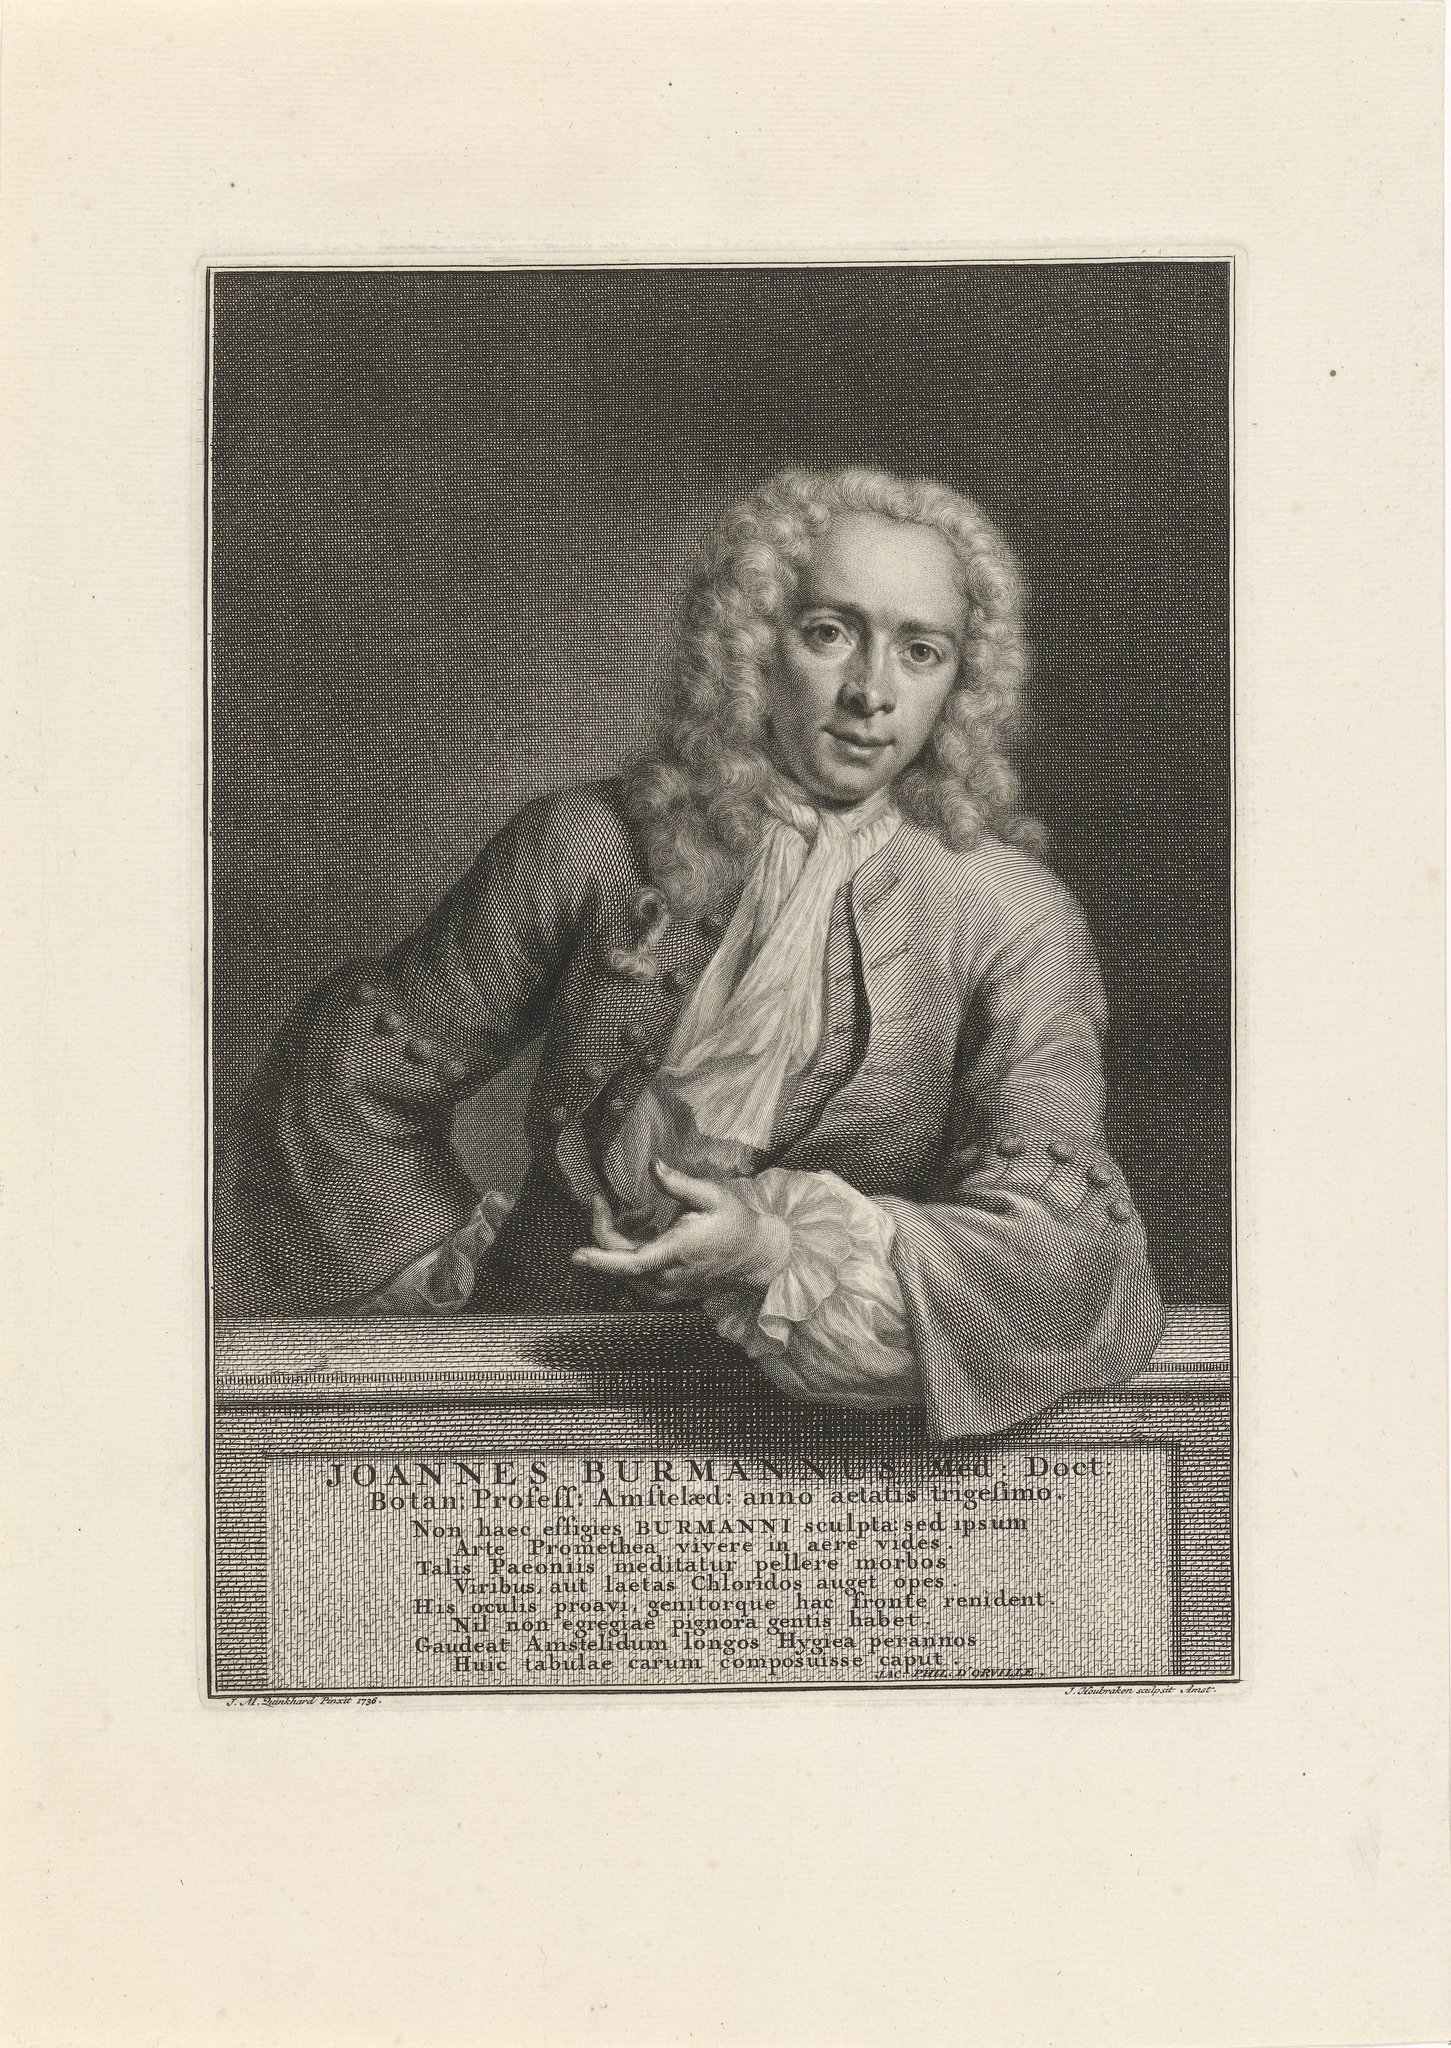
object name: print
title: Portret van Johannes Burman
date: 1736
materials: paper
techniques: engraving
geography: amsterdam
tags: hoogleraar, johannes burman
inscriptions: collector's mark: Lugt 2228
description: Portret ten halven lijve van Johannes Burman, achter een plint, waarbij zijn linkerhand over de rand steekt. Op de plint zijn naam en gegevens in twee regels in het Latijn. Daaronder een achtregelig vers in het Latijn.